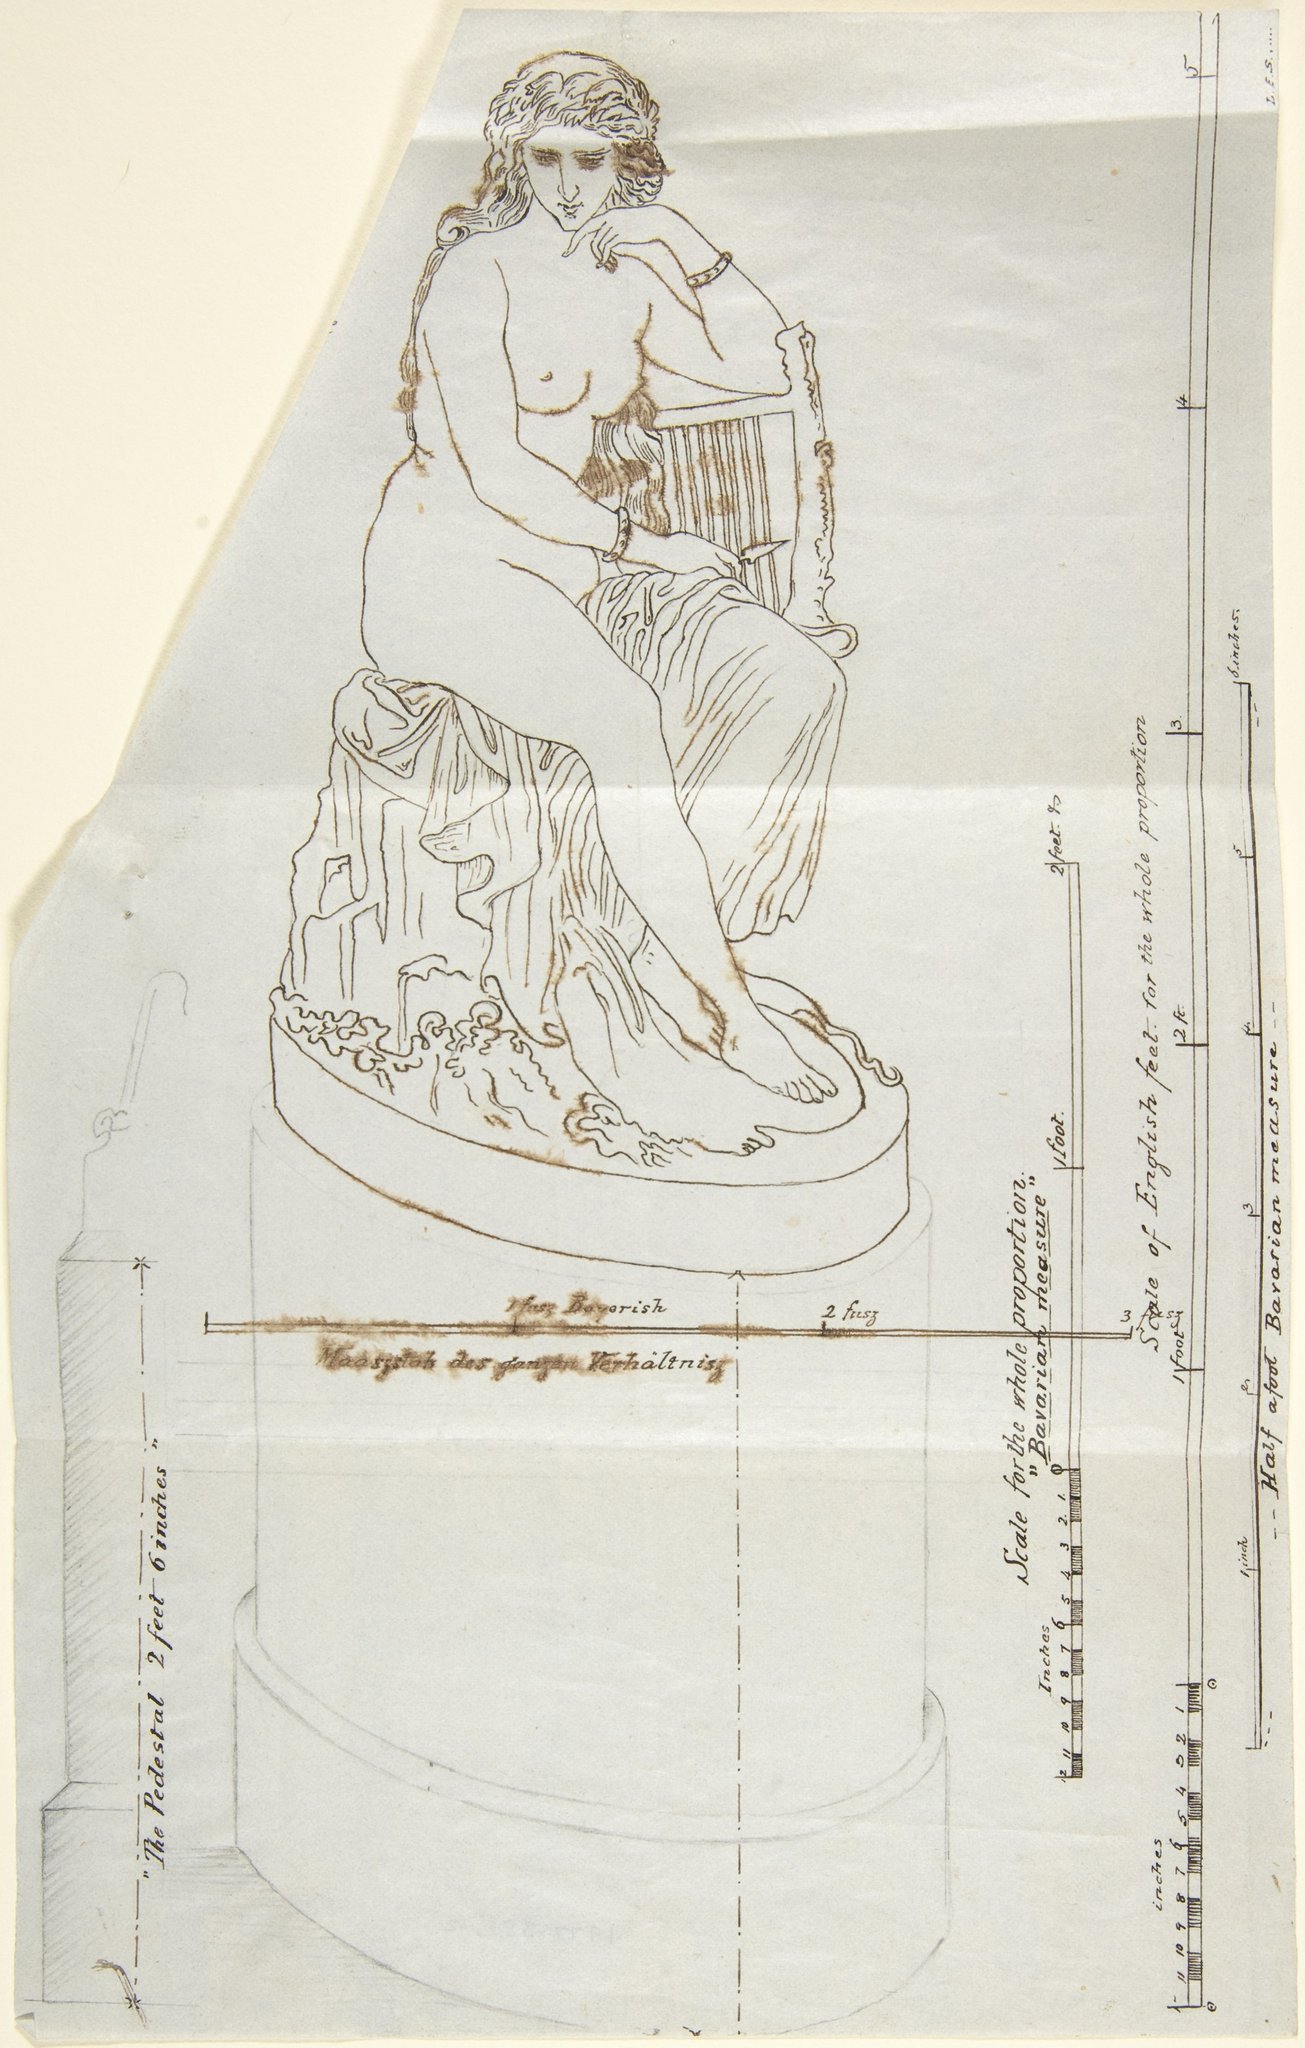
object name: drawing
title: Sketch of a statue: Nymph (or Nymph of the Rhine) by Ludwig Michael Schwanthaler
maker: franz xaver schwanthaler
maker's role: artist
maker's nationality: german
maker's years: 1799-1854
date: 1850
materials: graphite, ink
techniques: pen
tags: musical instruments,female nudes